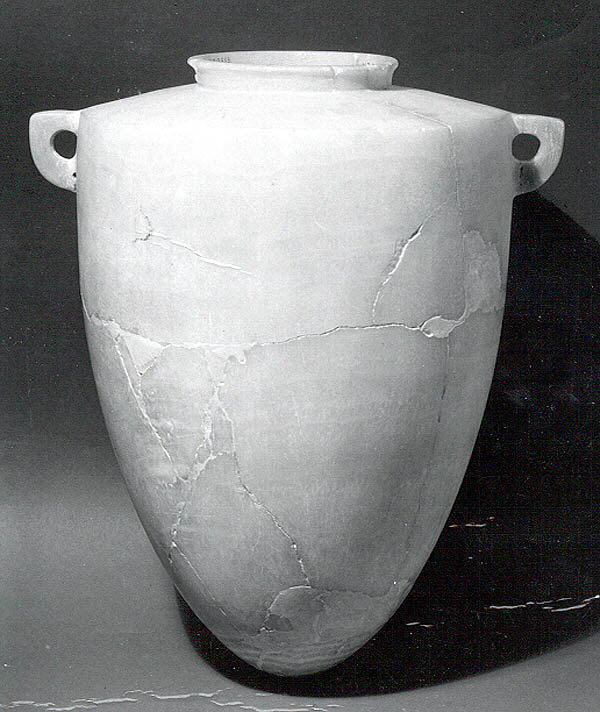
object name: jar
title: Jar of Egyptianizing type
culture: assyrian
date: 700-601 BCE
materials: alabaster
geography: mesopotamia